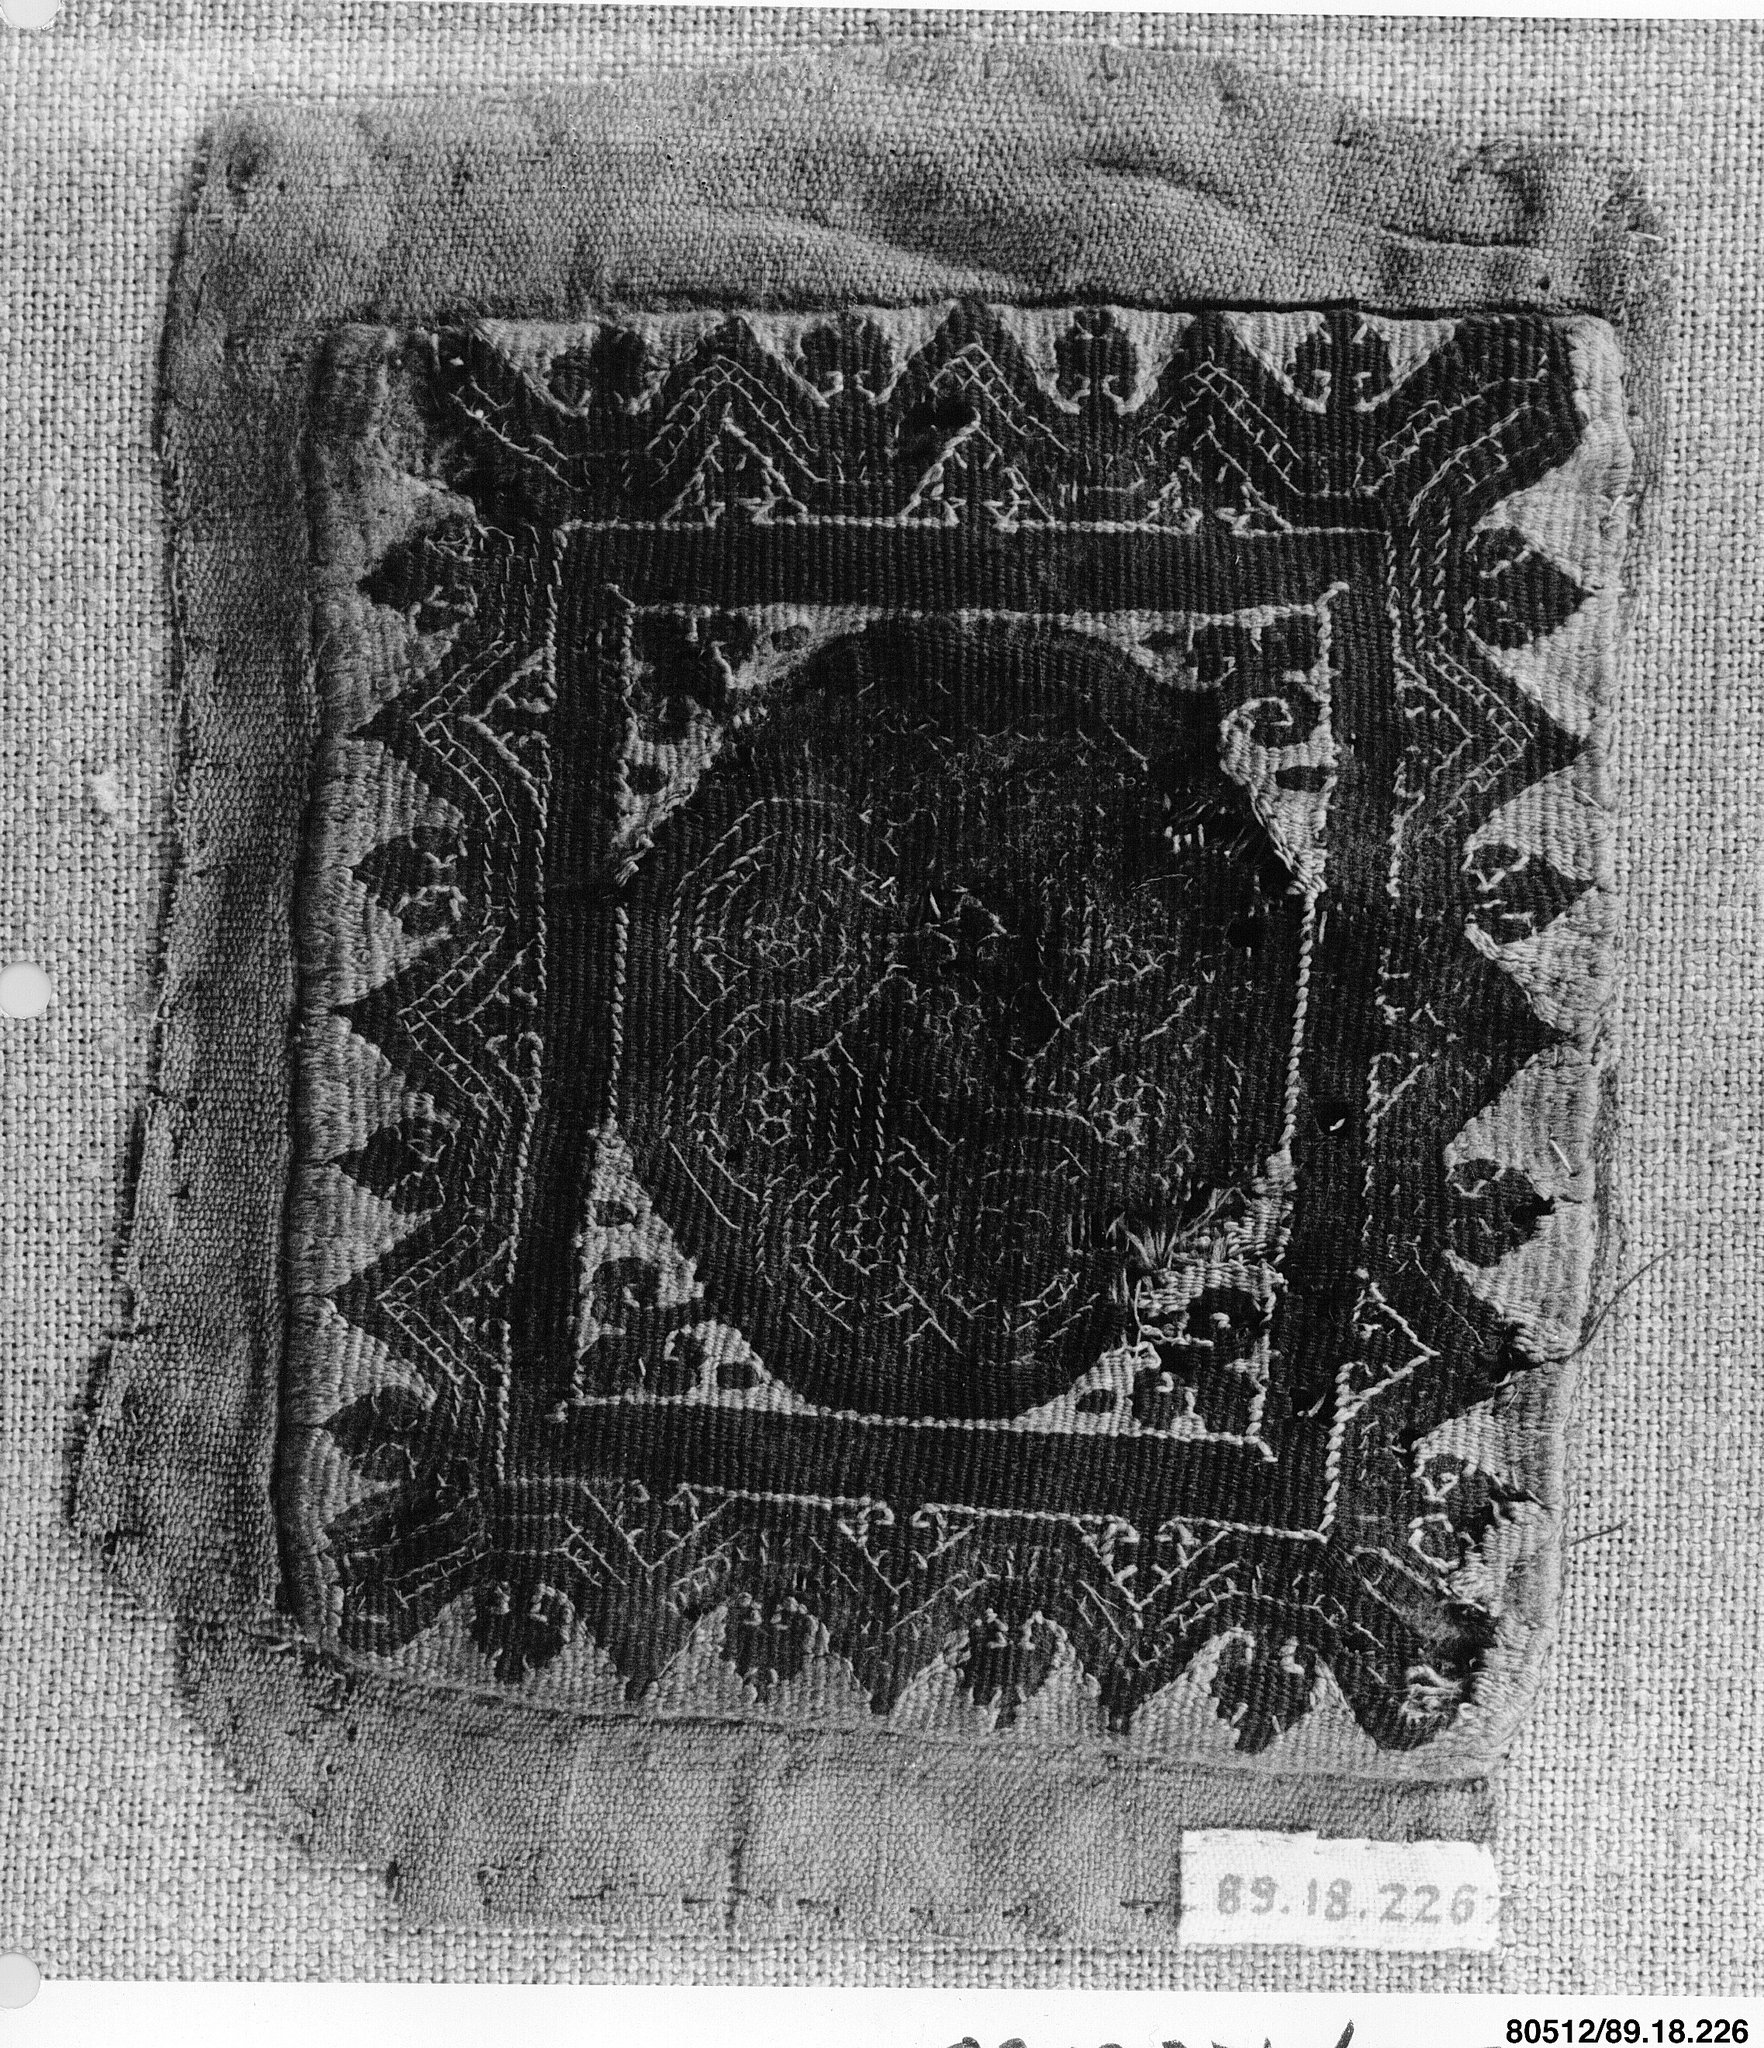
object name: textile fragment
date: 201-400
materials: linen, wool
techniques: weave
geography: egypt